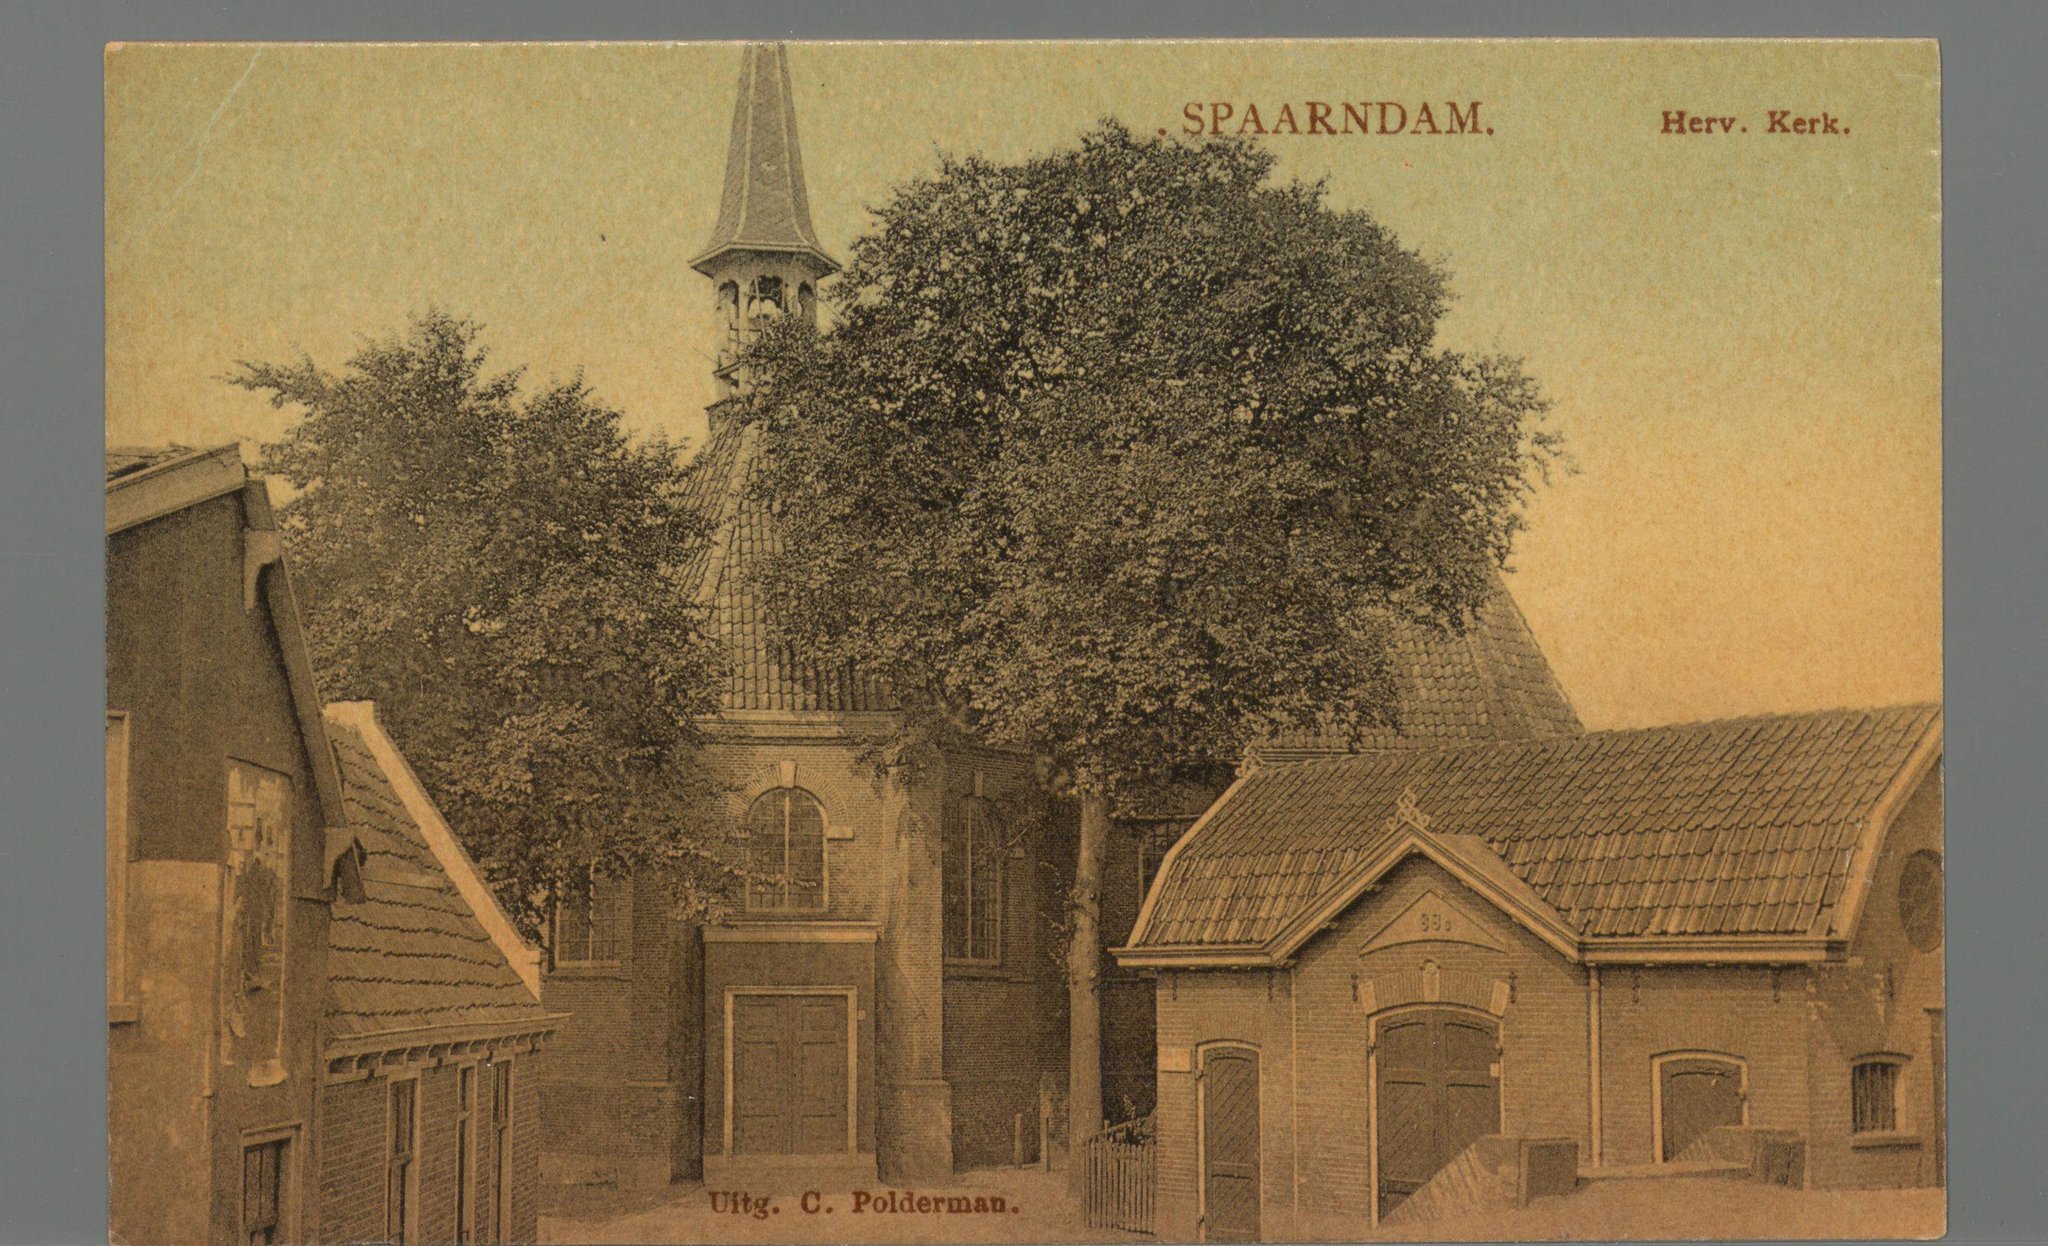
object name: ansichtkaart, prentbriefkaart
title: Spaarndam. Herv. Kerk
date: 1906-1919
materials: cardboard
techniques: photograph, iris print, lithograph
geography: spaarndam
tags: church (exterior)